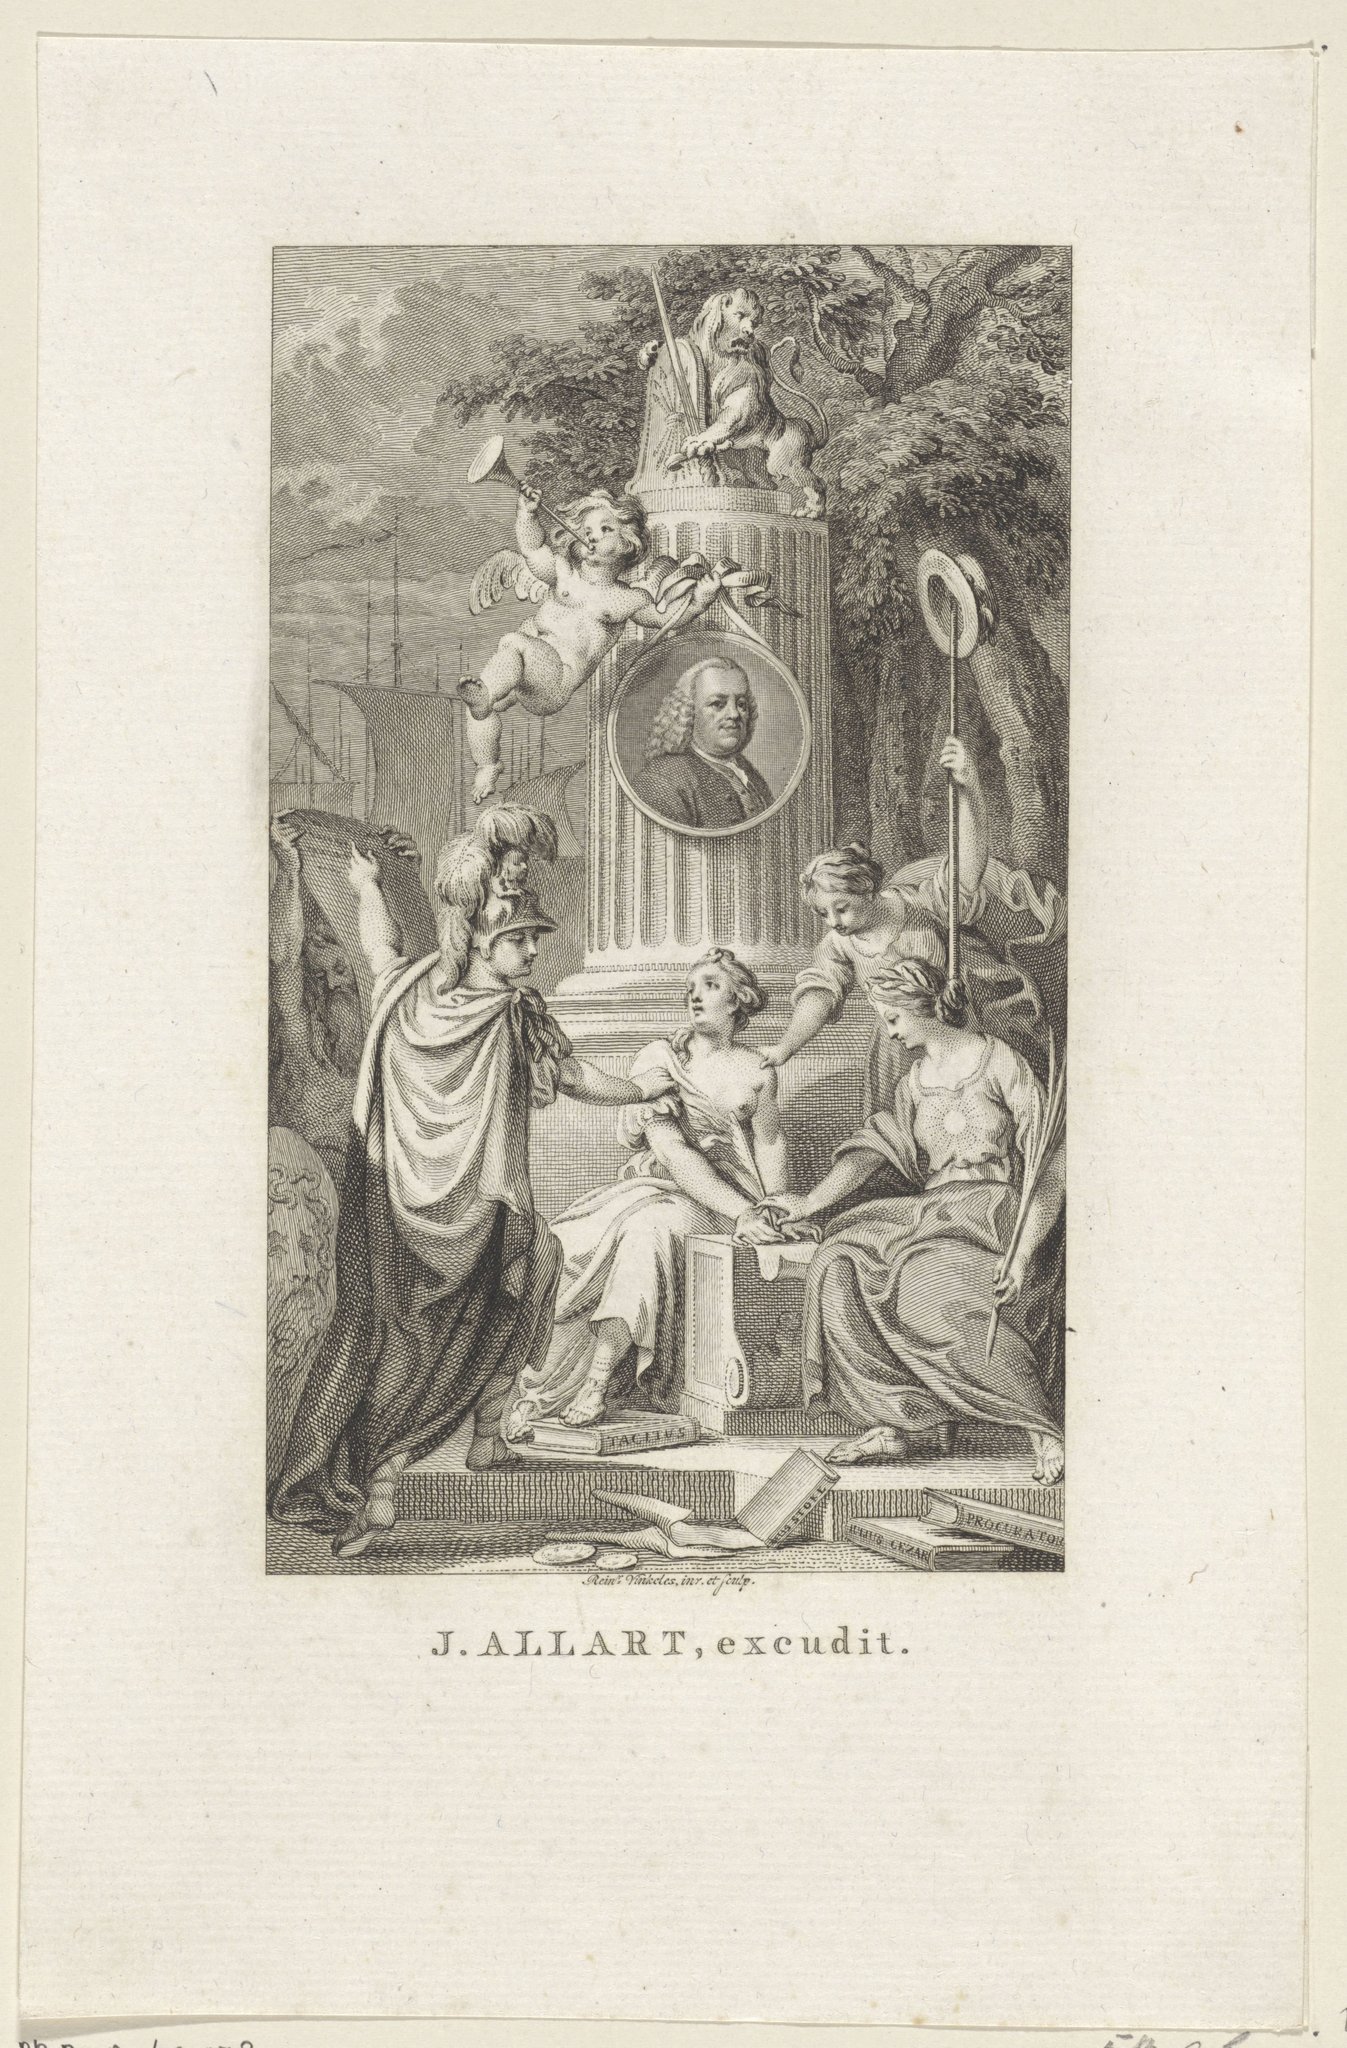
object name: titelblad, titelpagina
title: Portret van Jan Wagenaar met allegorische figuren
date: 1788-1790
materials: paper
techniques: engraving, etching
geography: amsterdam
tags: jan wagenaar, truth; 'verità' (ripa), 'historia'; 'historia' (ripa), freedom, liberty; 'libertà' (ripa)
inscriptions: collector's mark: Lugt 240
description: Geschiedenis schrijft omringd door de Waarheid, Vrijheid en Minerva. Achter hen een zuil met het portret van de schrijver Jan Wagenaar.